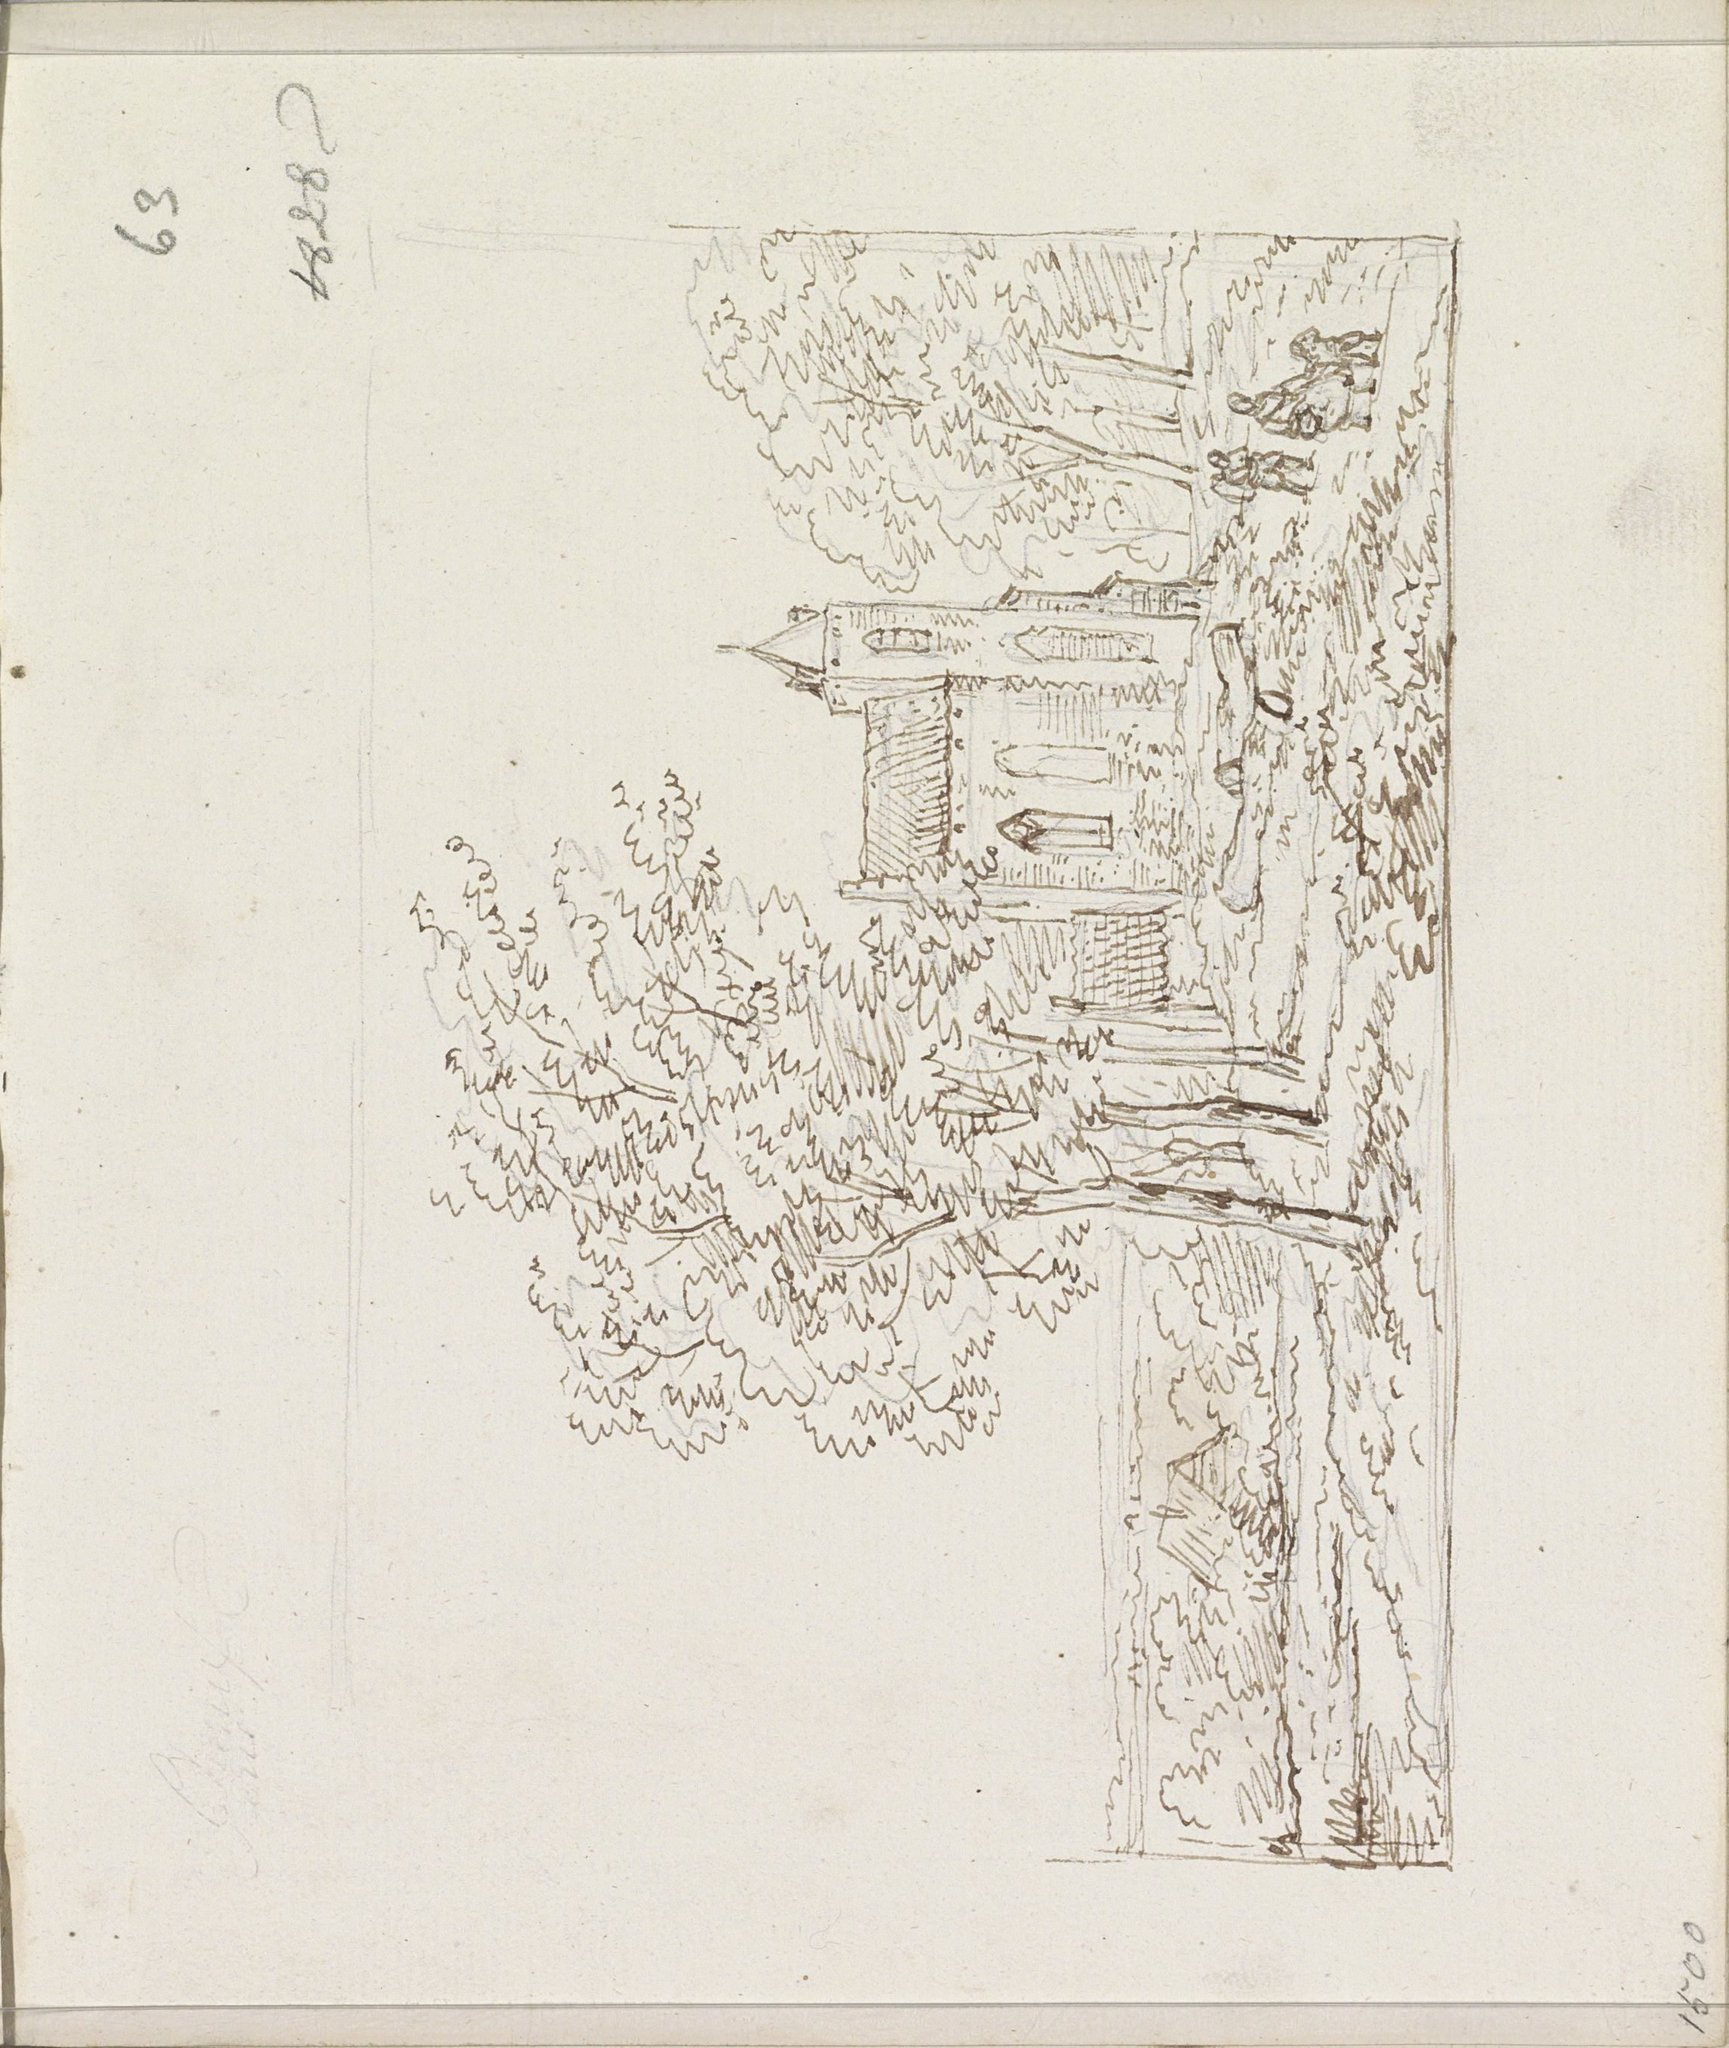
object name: sketchbook leaf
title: Heuvellandschap met een kerk en figuren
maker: andreas schelfhout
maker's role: draughtsman, painter, print maker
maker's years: 1787-1870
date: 1825-1829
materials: ink, paper, pencil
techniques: pen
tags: church (exterior), city-view, and landscape with man-made constructions (+ city(-scape) with figures, staffage)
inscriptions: number: ‘63/ 28?/ 1500’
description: Blad 78 recto uit een schetsboek met 95 bladen.